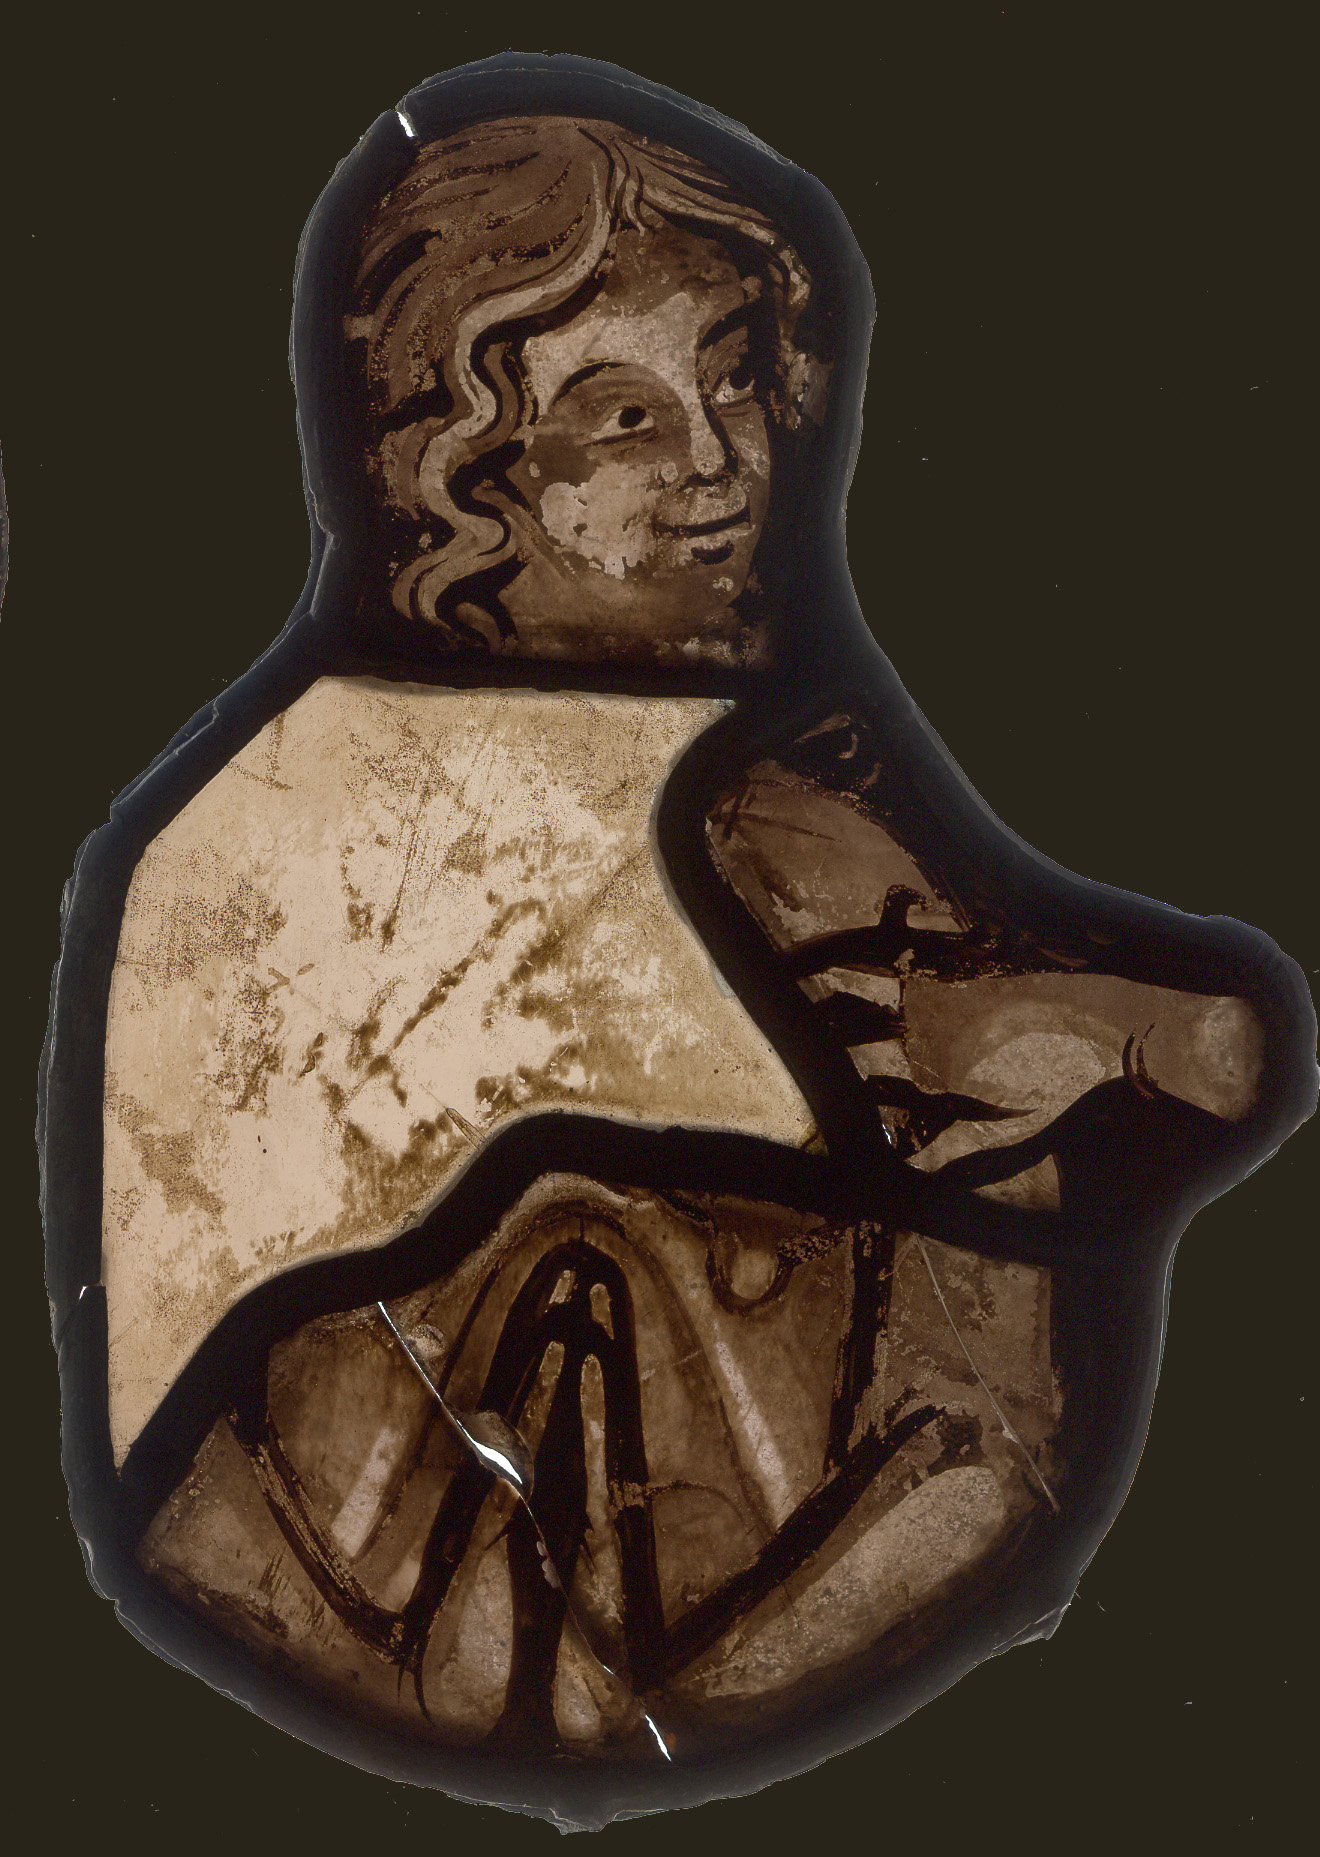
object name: fragment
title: Stained Glass Fragment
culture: french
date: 1200-1215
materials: glass